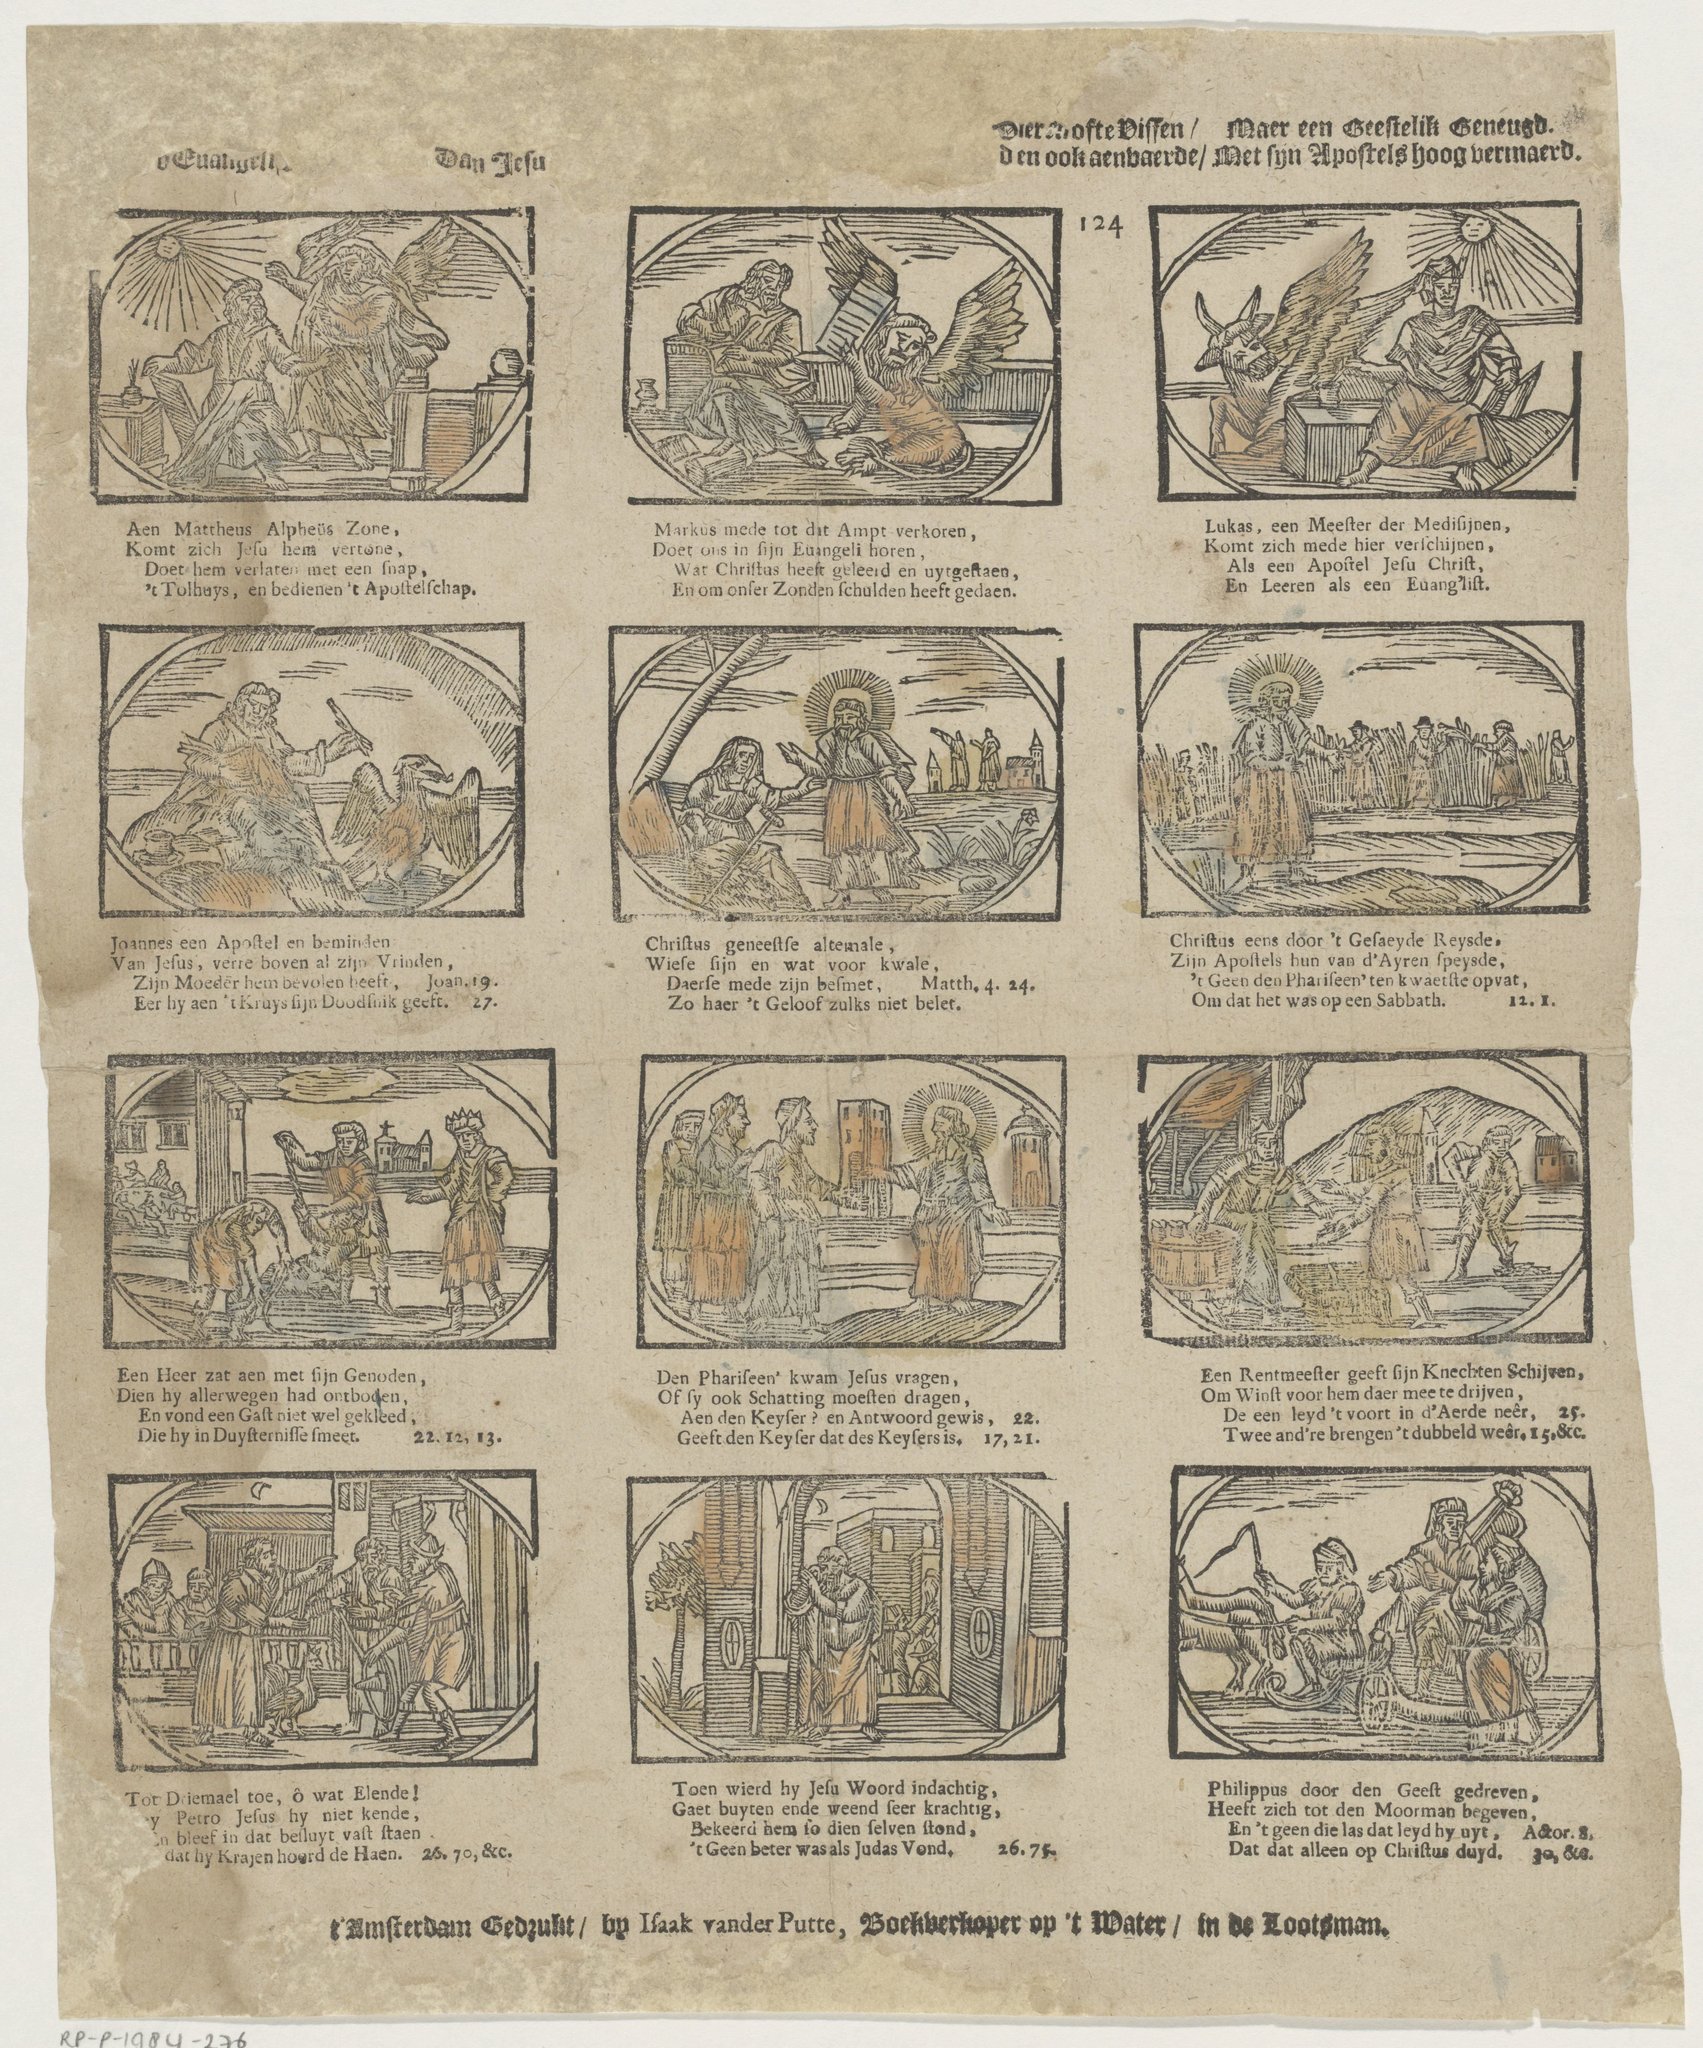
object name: print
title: [Ziet eens Leesgierige Jeugd / Wat men u weer op komt Dissen / 't En zijn geen] dieren ofte vissen (...)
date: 1723-1748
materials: paper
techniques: colour, letterpress printing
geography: amsterdam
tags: evangelists, usually with books or scrolls (not in biblical context), the four evangelists ~ the four main prophets, new testament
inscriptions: collector's mark: Lugt 2760, collector's mark: Lugt 2228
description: Blad met 12 voorstellingen van de vier evangelisten en van verhalen uit het Nieuwe Testament. Onder elke afbeelding een vierregelig vers en een verwijzing naar de bijbehorende Bijbeltekst. Genummerd boven: 124.